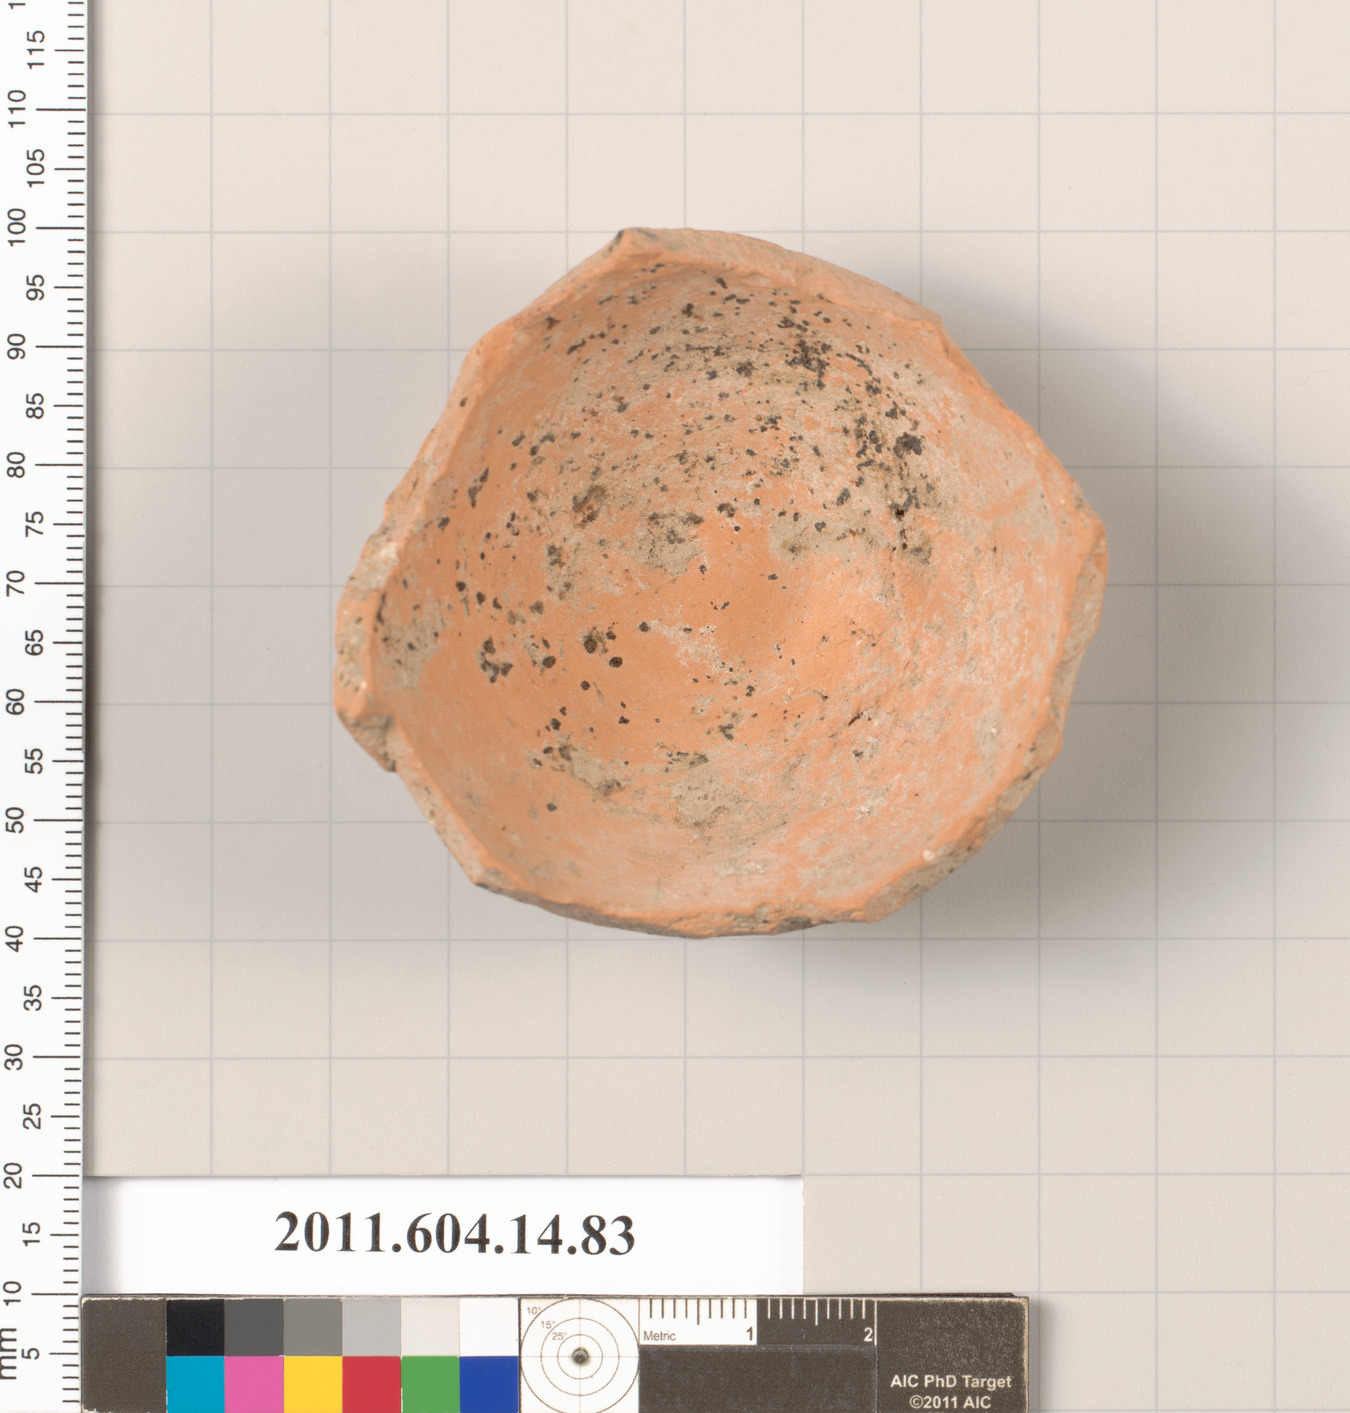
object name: undetermined shape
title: Terracotta fragment of an undetermined shape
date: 600-401 BCE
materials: terracotta